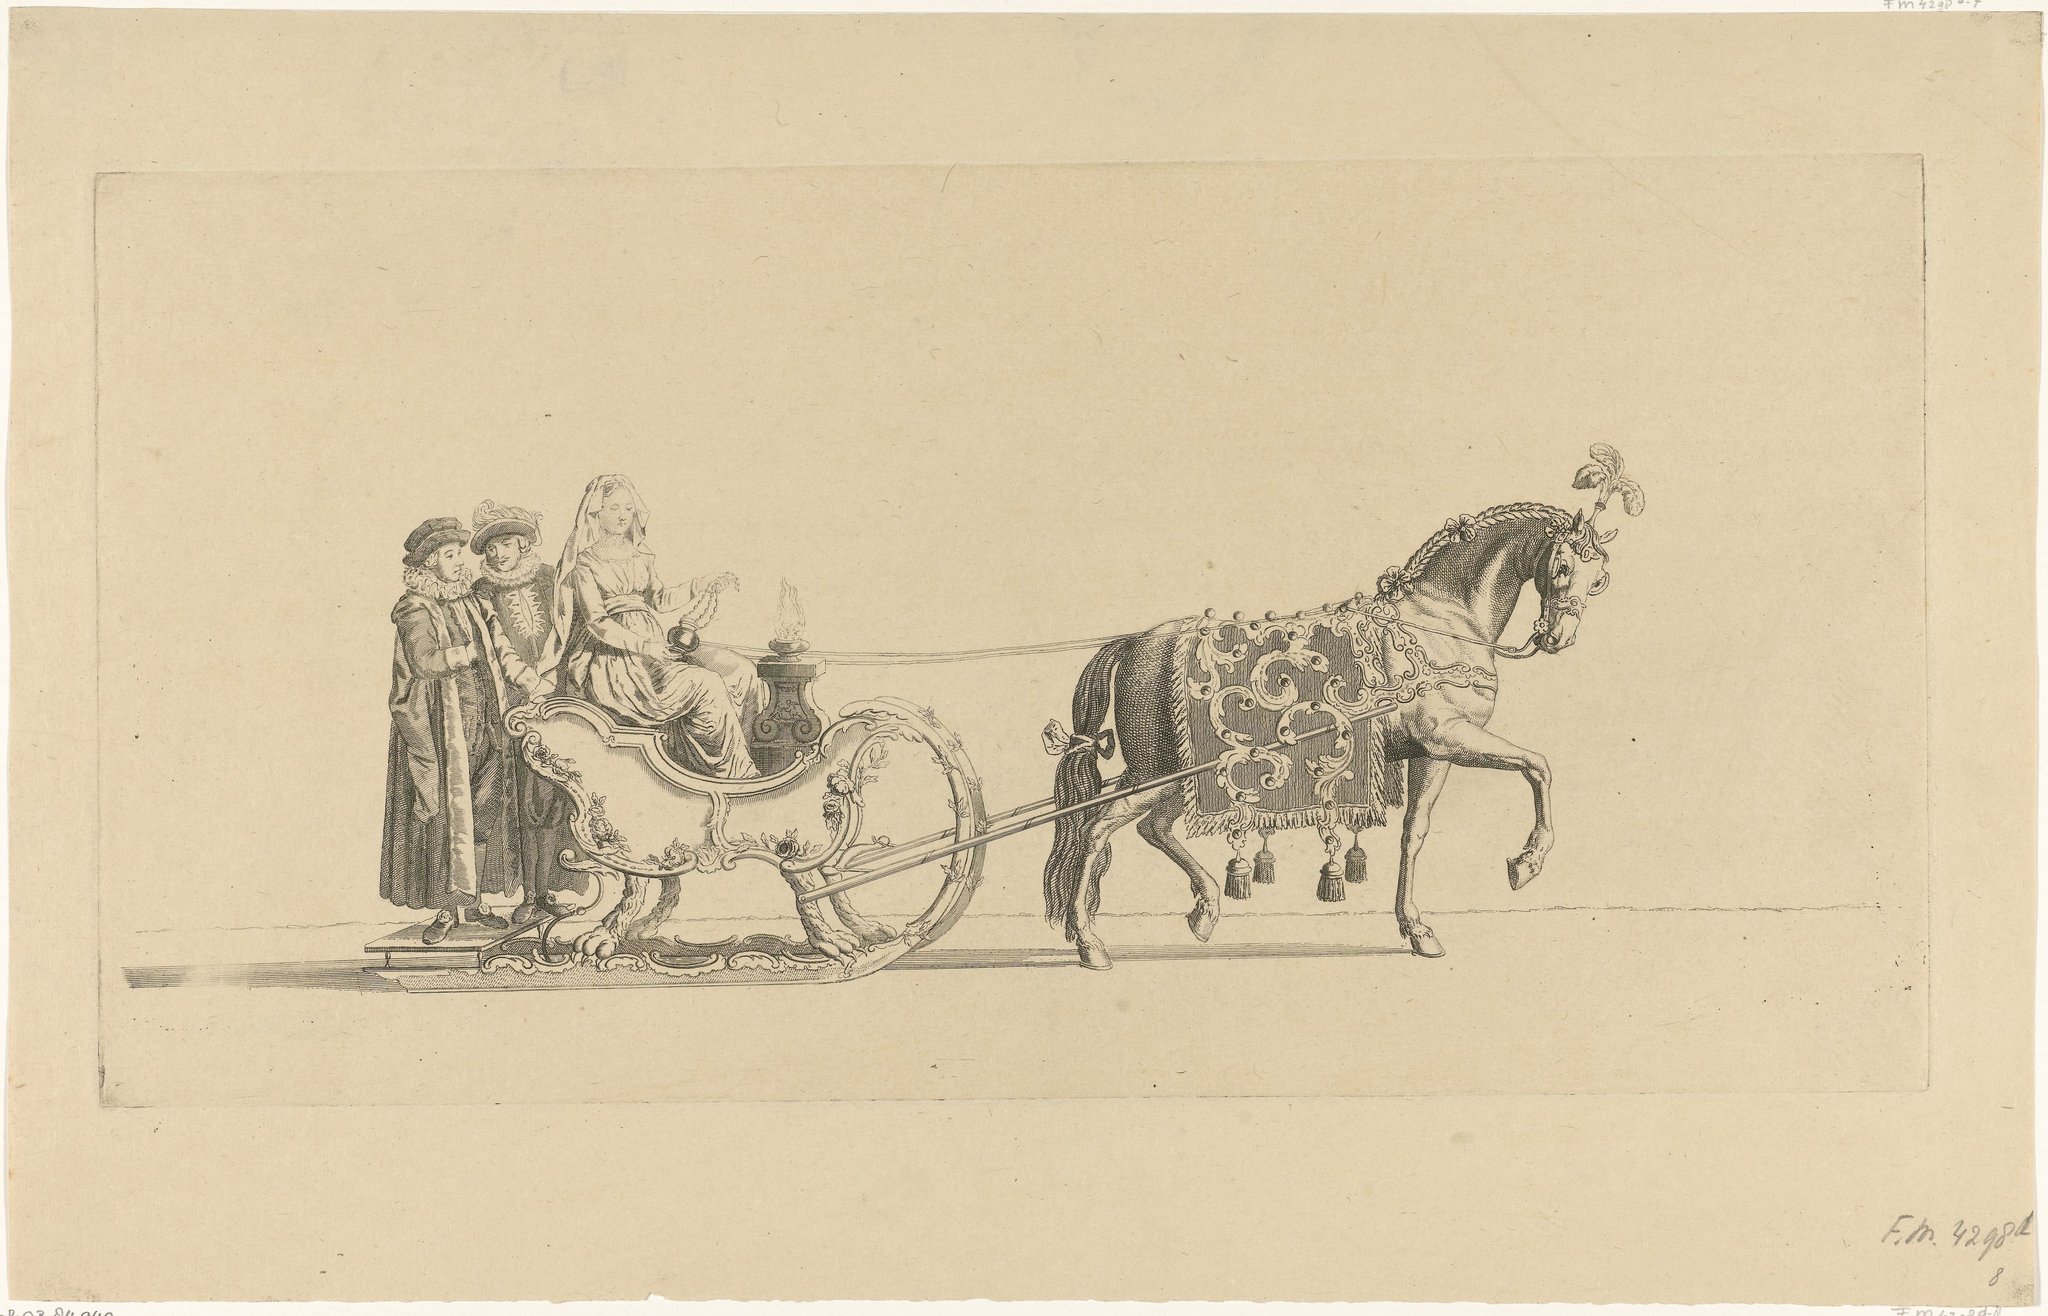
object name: print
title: Achtste slede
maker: nicolaas van der worm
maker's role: draughtsman, print maker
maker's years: 1757-1828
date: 1776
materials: paper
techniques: etching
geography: northern netherlands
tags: allegorical representations ~ religion; 'religione', 'religione de ss. mauritio e lazaro', 'religione vera christiana' (ripa), sledge, sleigh (winter sports), commemoration of the founding of a university, leiden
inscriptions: collector's mark: Lugt 240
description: De achtste slede in de optocht. Een slede met de personificatie van de Godsdienst, getrokken door een paard. Onderdeel van een reeks van twaalf platen (etsdruk vóór het nummer en op ander papier) van de sledevaart op 24 januari 1776 georganiseerd door het Leidse genootschap Veniam Pro Laude bij gelegenheid van het Tweede Eeuwfeest van het Leids Ontzet (3 oktober 1574) en de oprichting van de Universiteit van Leiden (8 februari 1575).